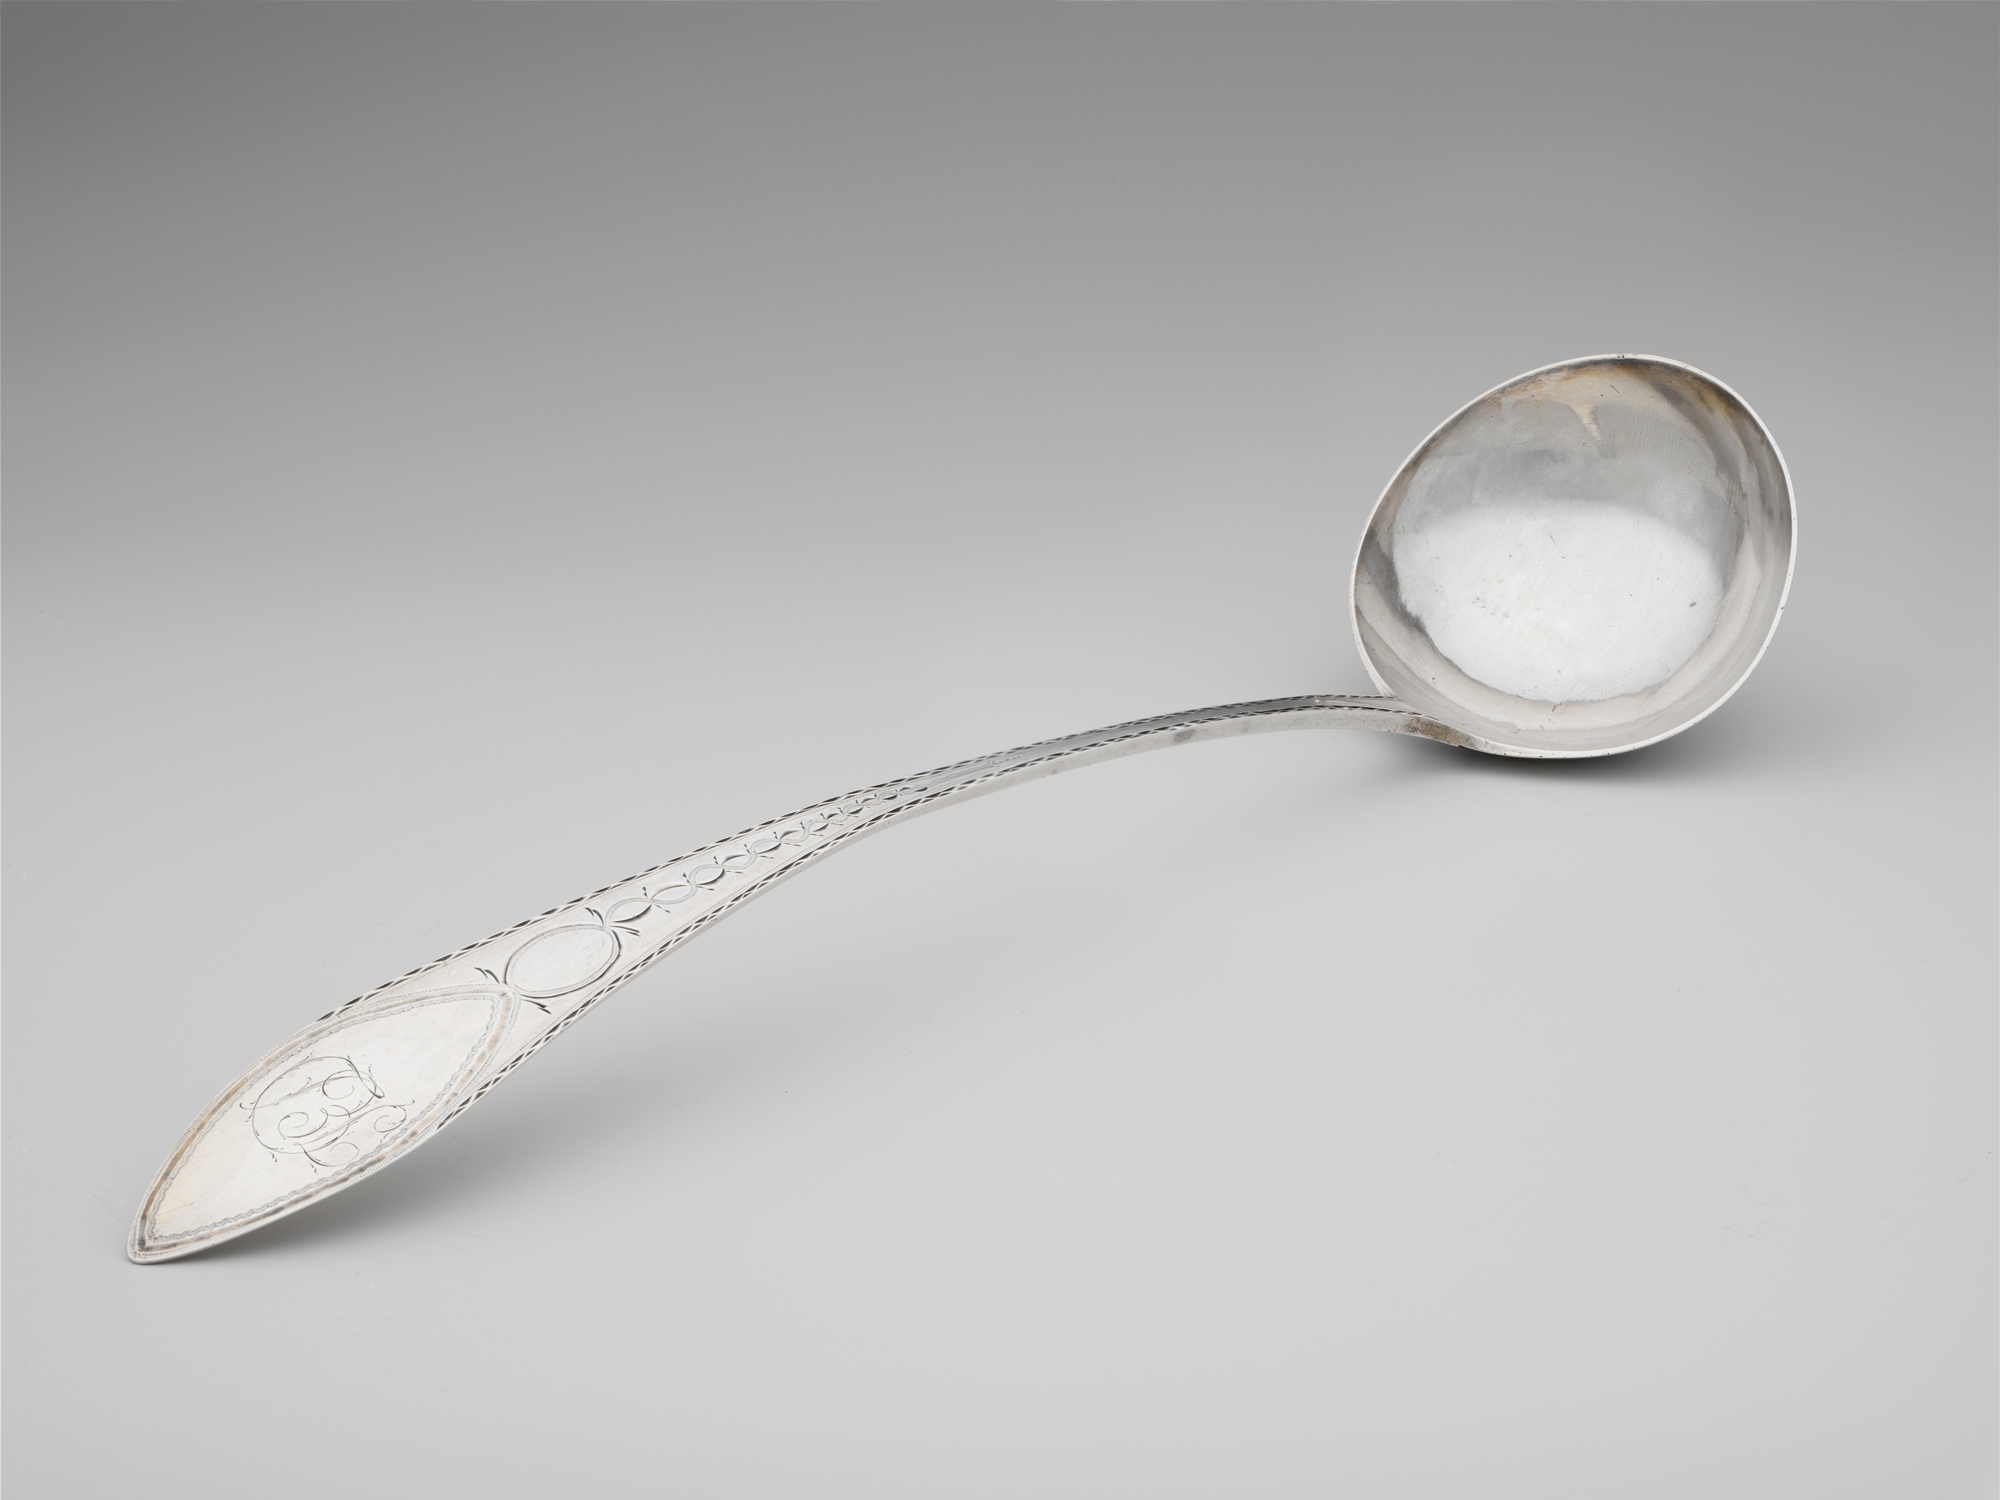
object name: ladle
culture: american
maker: standish barry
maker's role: maker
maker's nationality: american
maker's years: 1763-1844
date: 1790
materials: silver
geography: united states